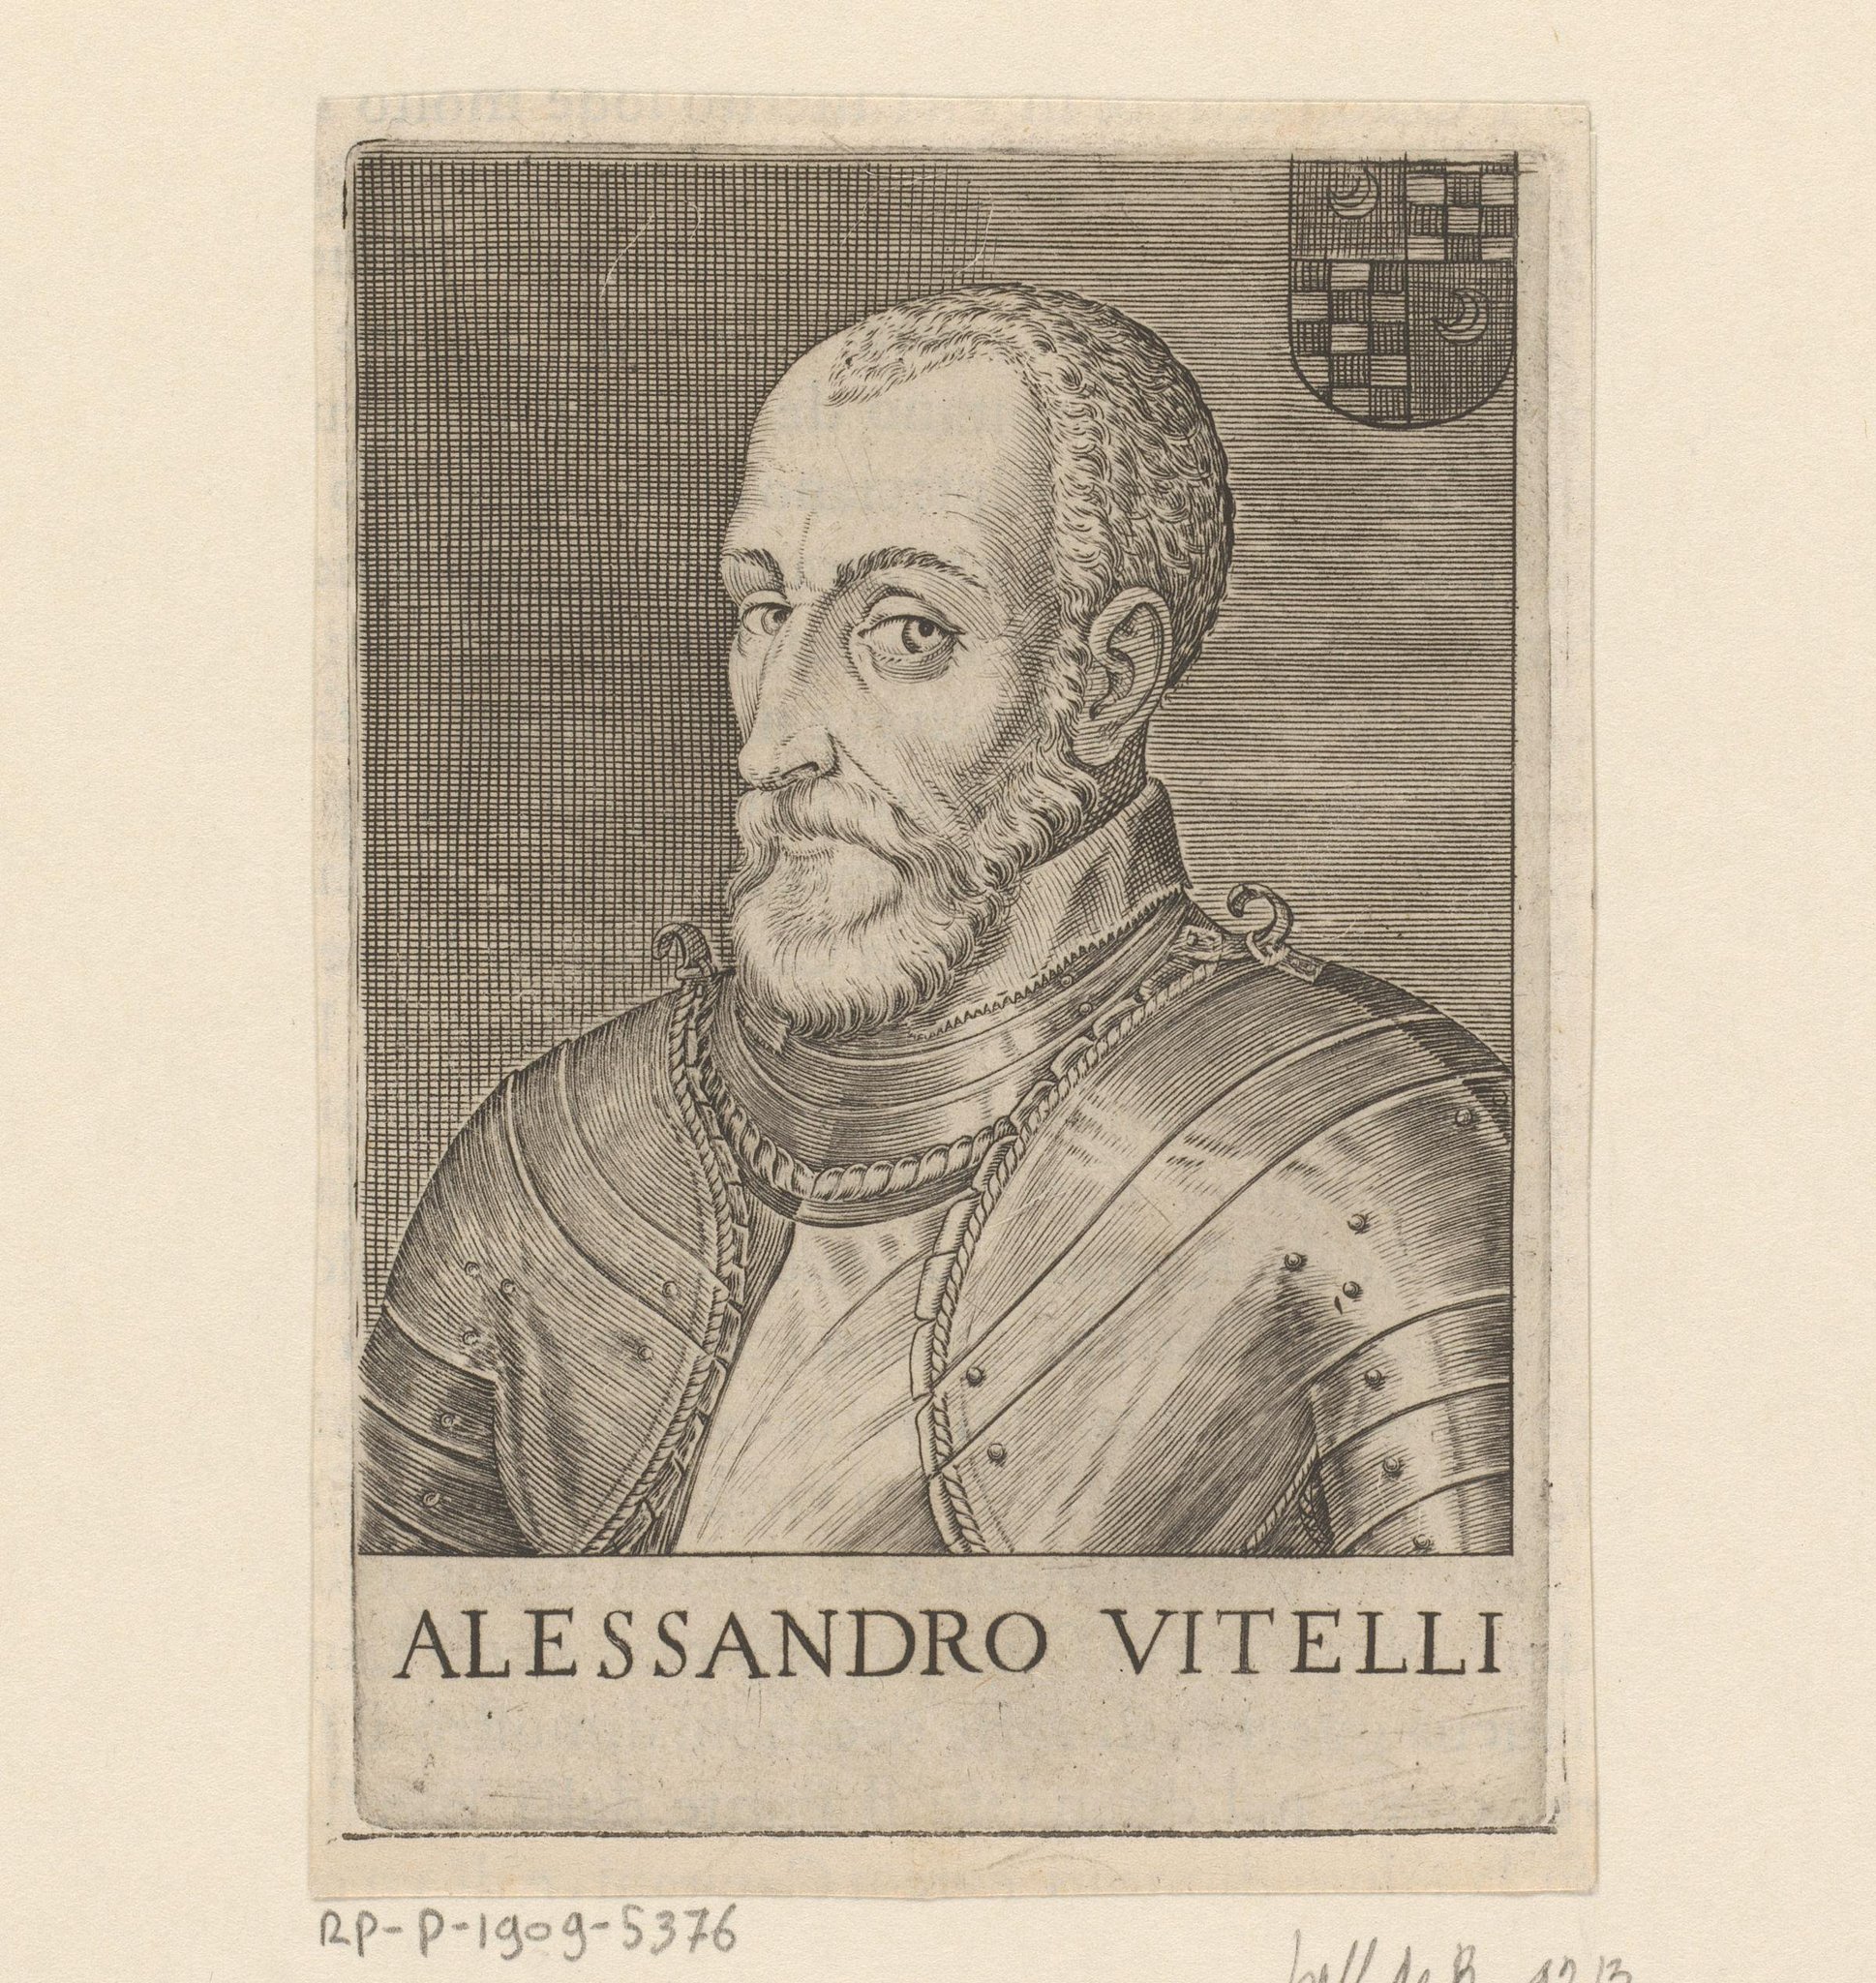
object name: print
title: Portret van legeraanvoerder Alesssandro Vitelli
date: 1646-1647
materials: paper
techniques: engraving, letterpress printing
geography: rome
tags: commander-in-chief, general, marshal, historical persons, armorial bearing, heraldry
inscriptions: collector's mark: Lugt 2228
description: Prent uit: Ritratti et elogii di capitani Illustri. Che ne'secoli moderni hanno gloriosamente guerreggiato. Rome: Filippo de'Rossi en Vitale Mascardi, 1646, p. 303. Prent ook gebruikt in dezelfde editie van 1647. Eerdere staten van prent in ieder geval gebruikt in: Ritratti et elogii di capitani Illustri. Rome: Pompilio Totti en Andrea Fei, 1635. En in: Ritratti di cento capitani illustri con li lor Fatti in guerra (…), Rome: Domenico Gigliotti, 1596.